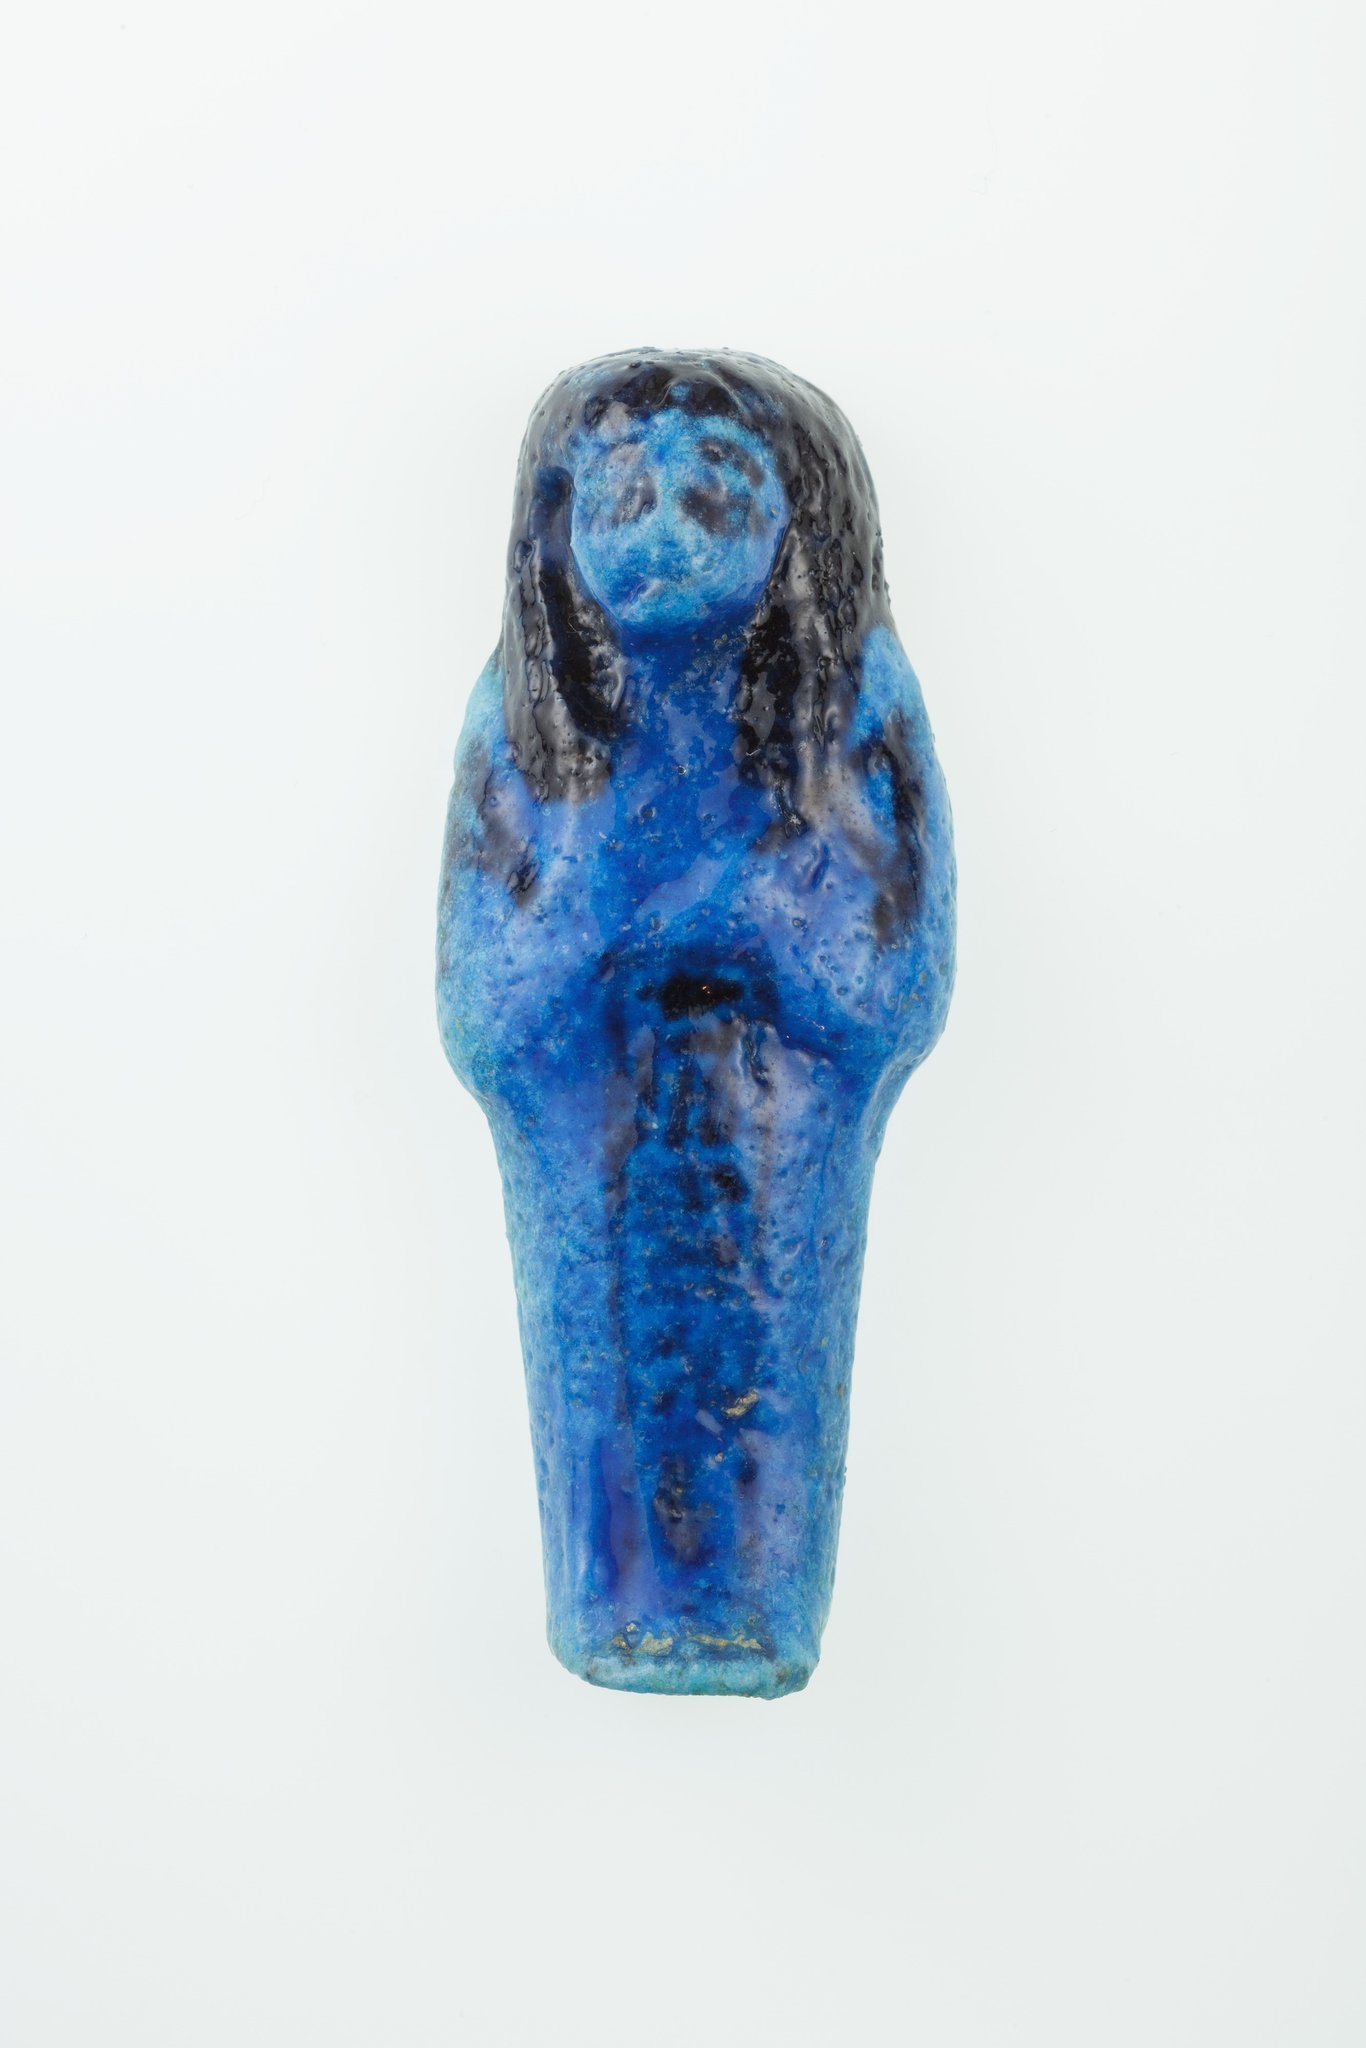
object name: shabti, worker, nauny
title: Worker Shabti of Nauny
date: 1050 BCE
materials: faience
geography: egypt